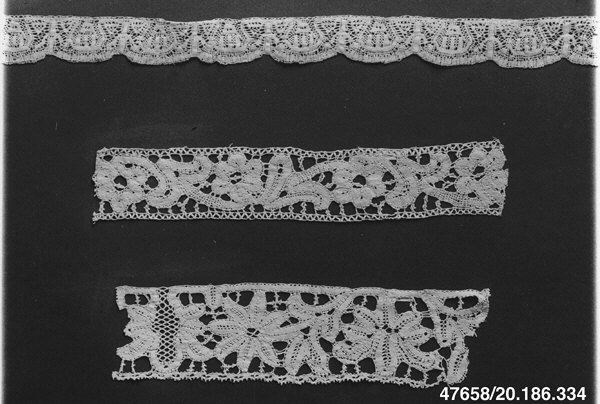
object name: edging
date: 1701-1800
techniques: lace